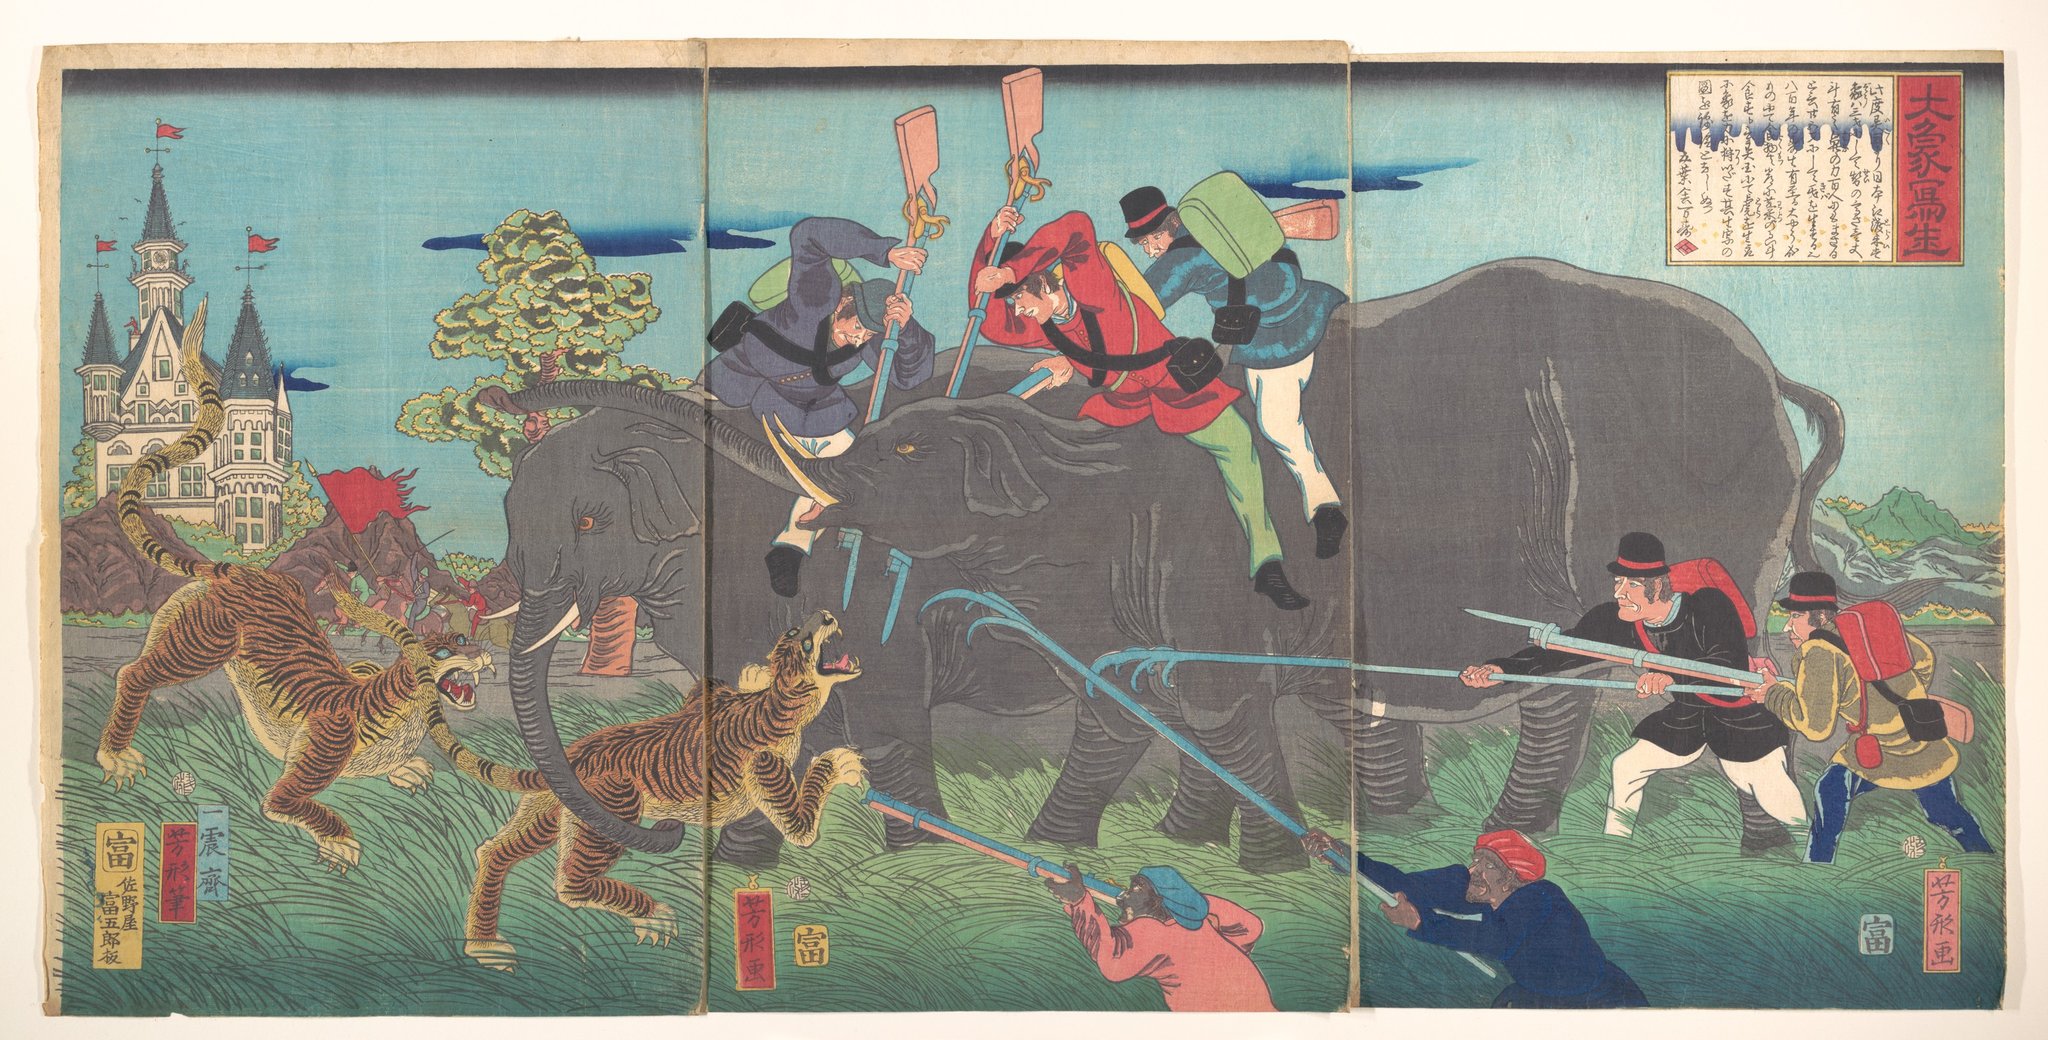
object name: woodblock print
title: Big Elephants Being Attacked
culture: japanese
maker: isshinsai yoshikata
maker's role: artist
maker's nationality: japanese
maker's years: 1841-1864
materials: ink, paper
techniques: woodblock print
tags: weapons,men,elephants,tigers